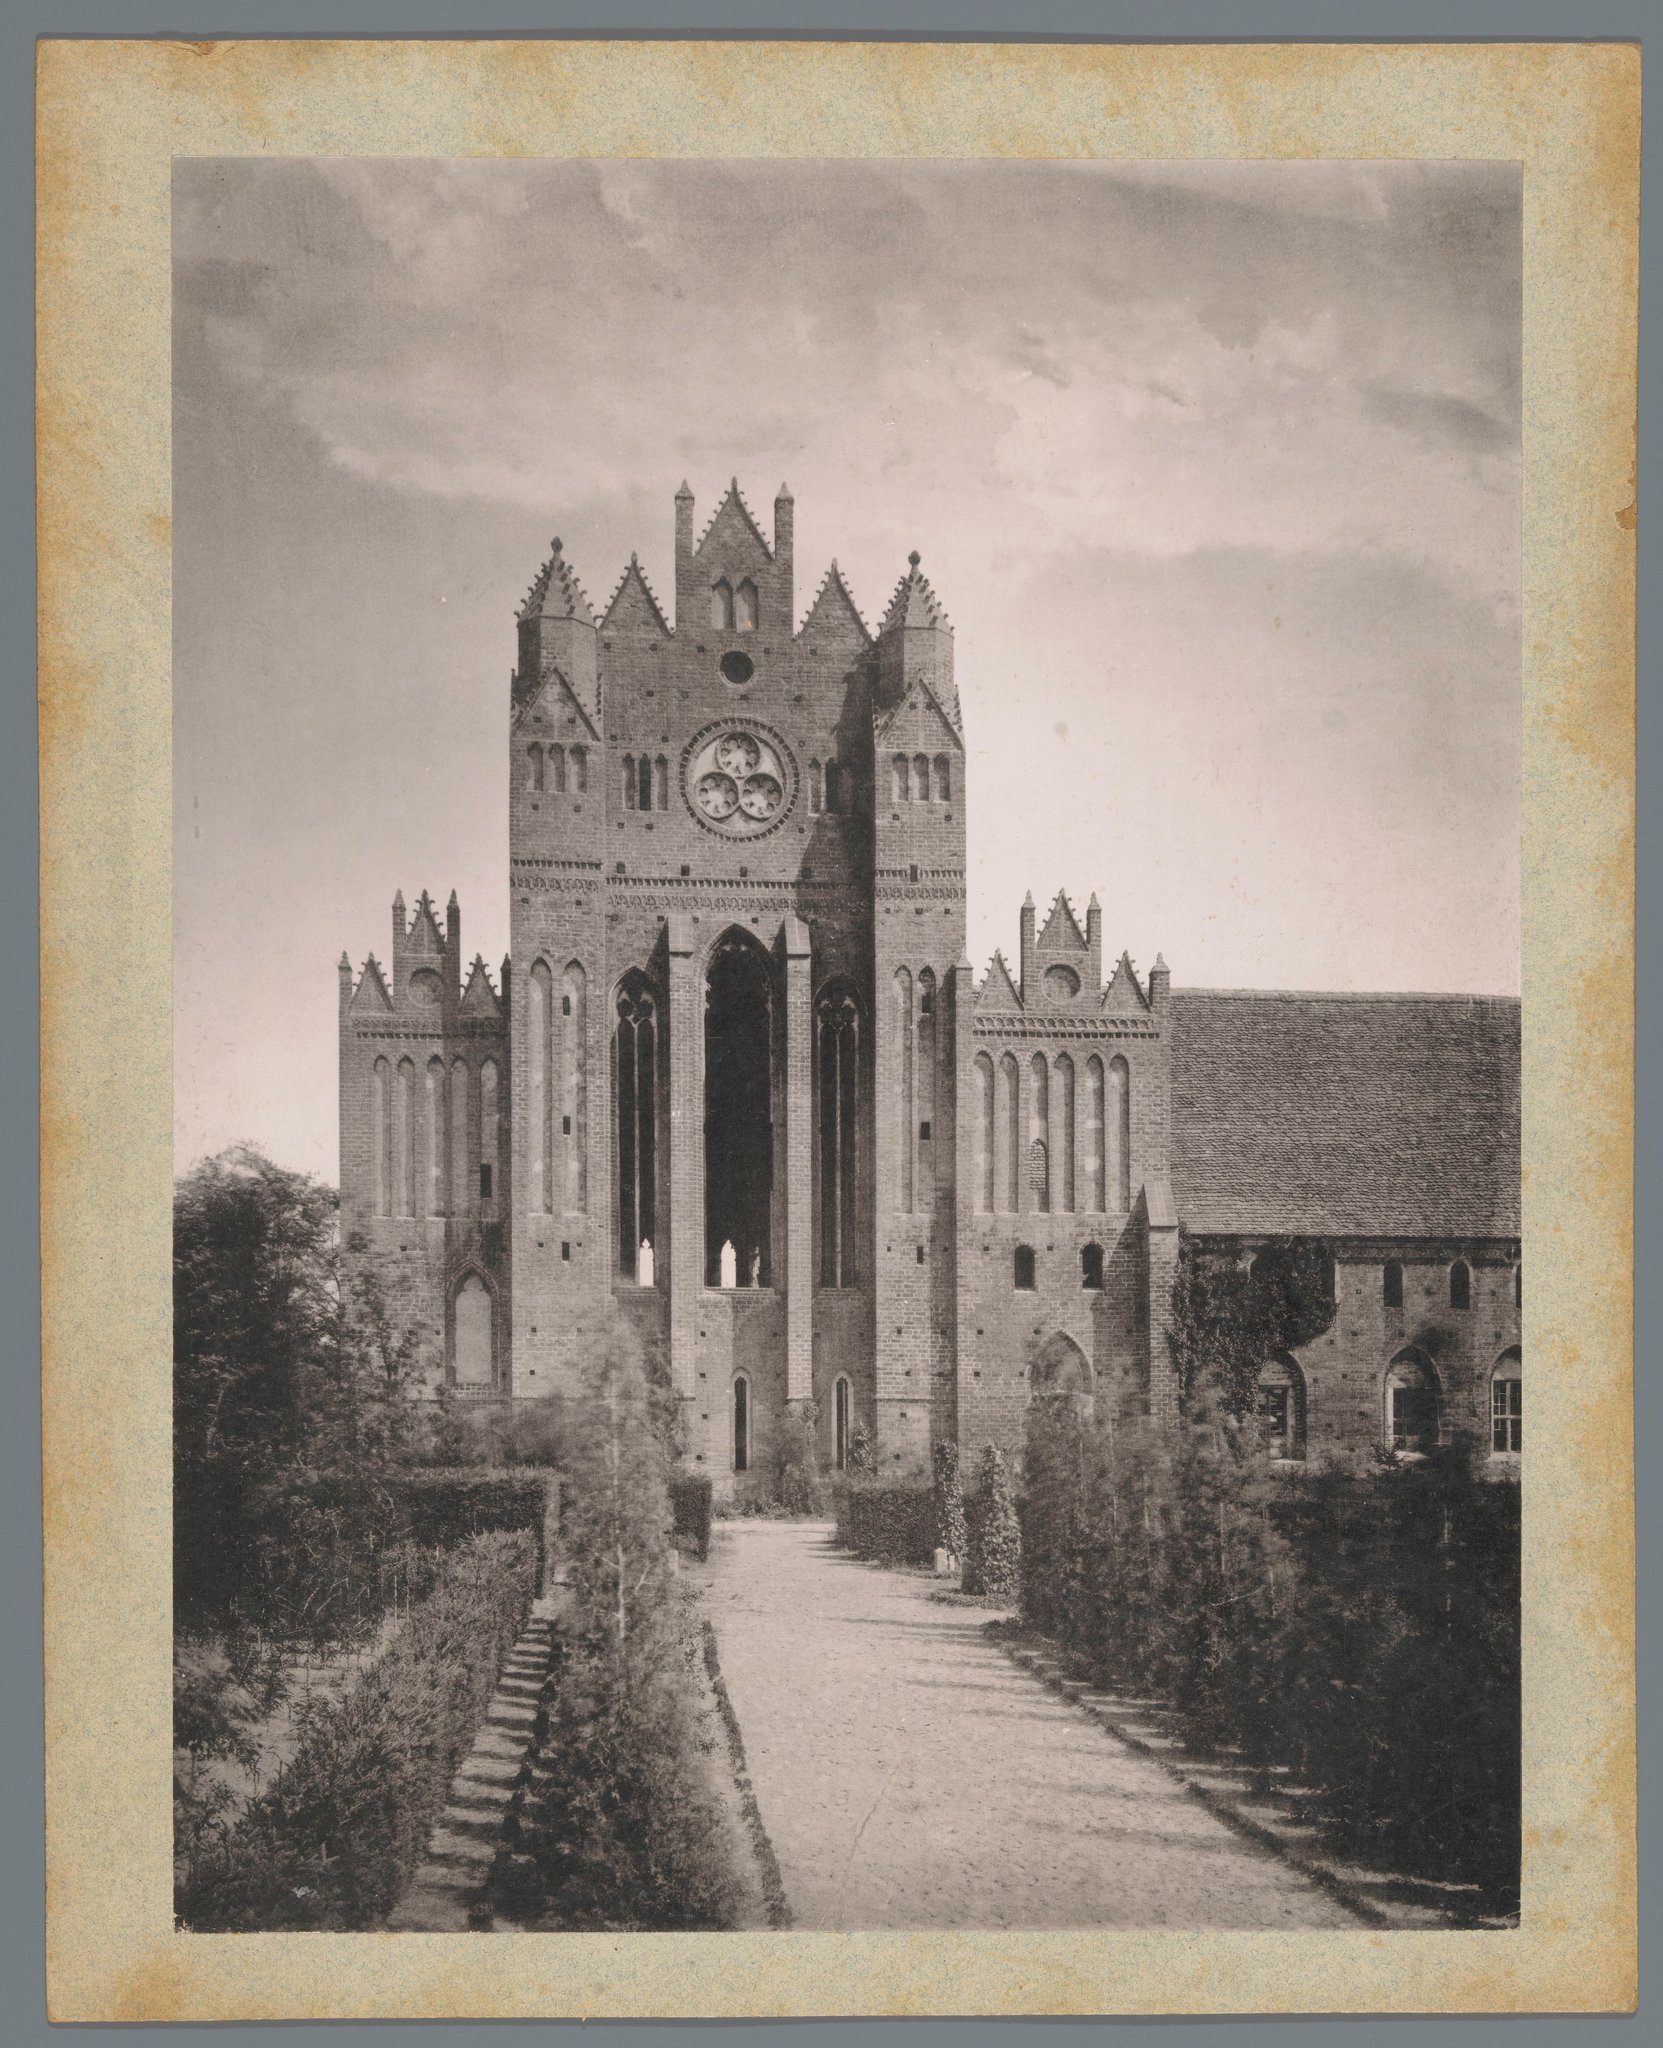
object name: photograph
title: Deel van de zijgevel van een kerk (vermoedelijk) in Frankrijk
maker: Anonymous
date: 1875-1900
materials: cardboard, paper, ink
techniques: photograph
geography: france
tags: trees, parts of church exterior and annexes: transept, church (exterior), façade (of house or building)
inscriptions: collector's mark: Lugt 3937